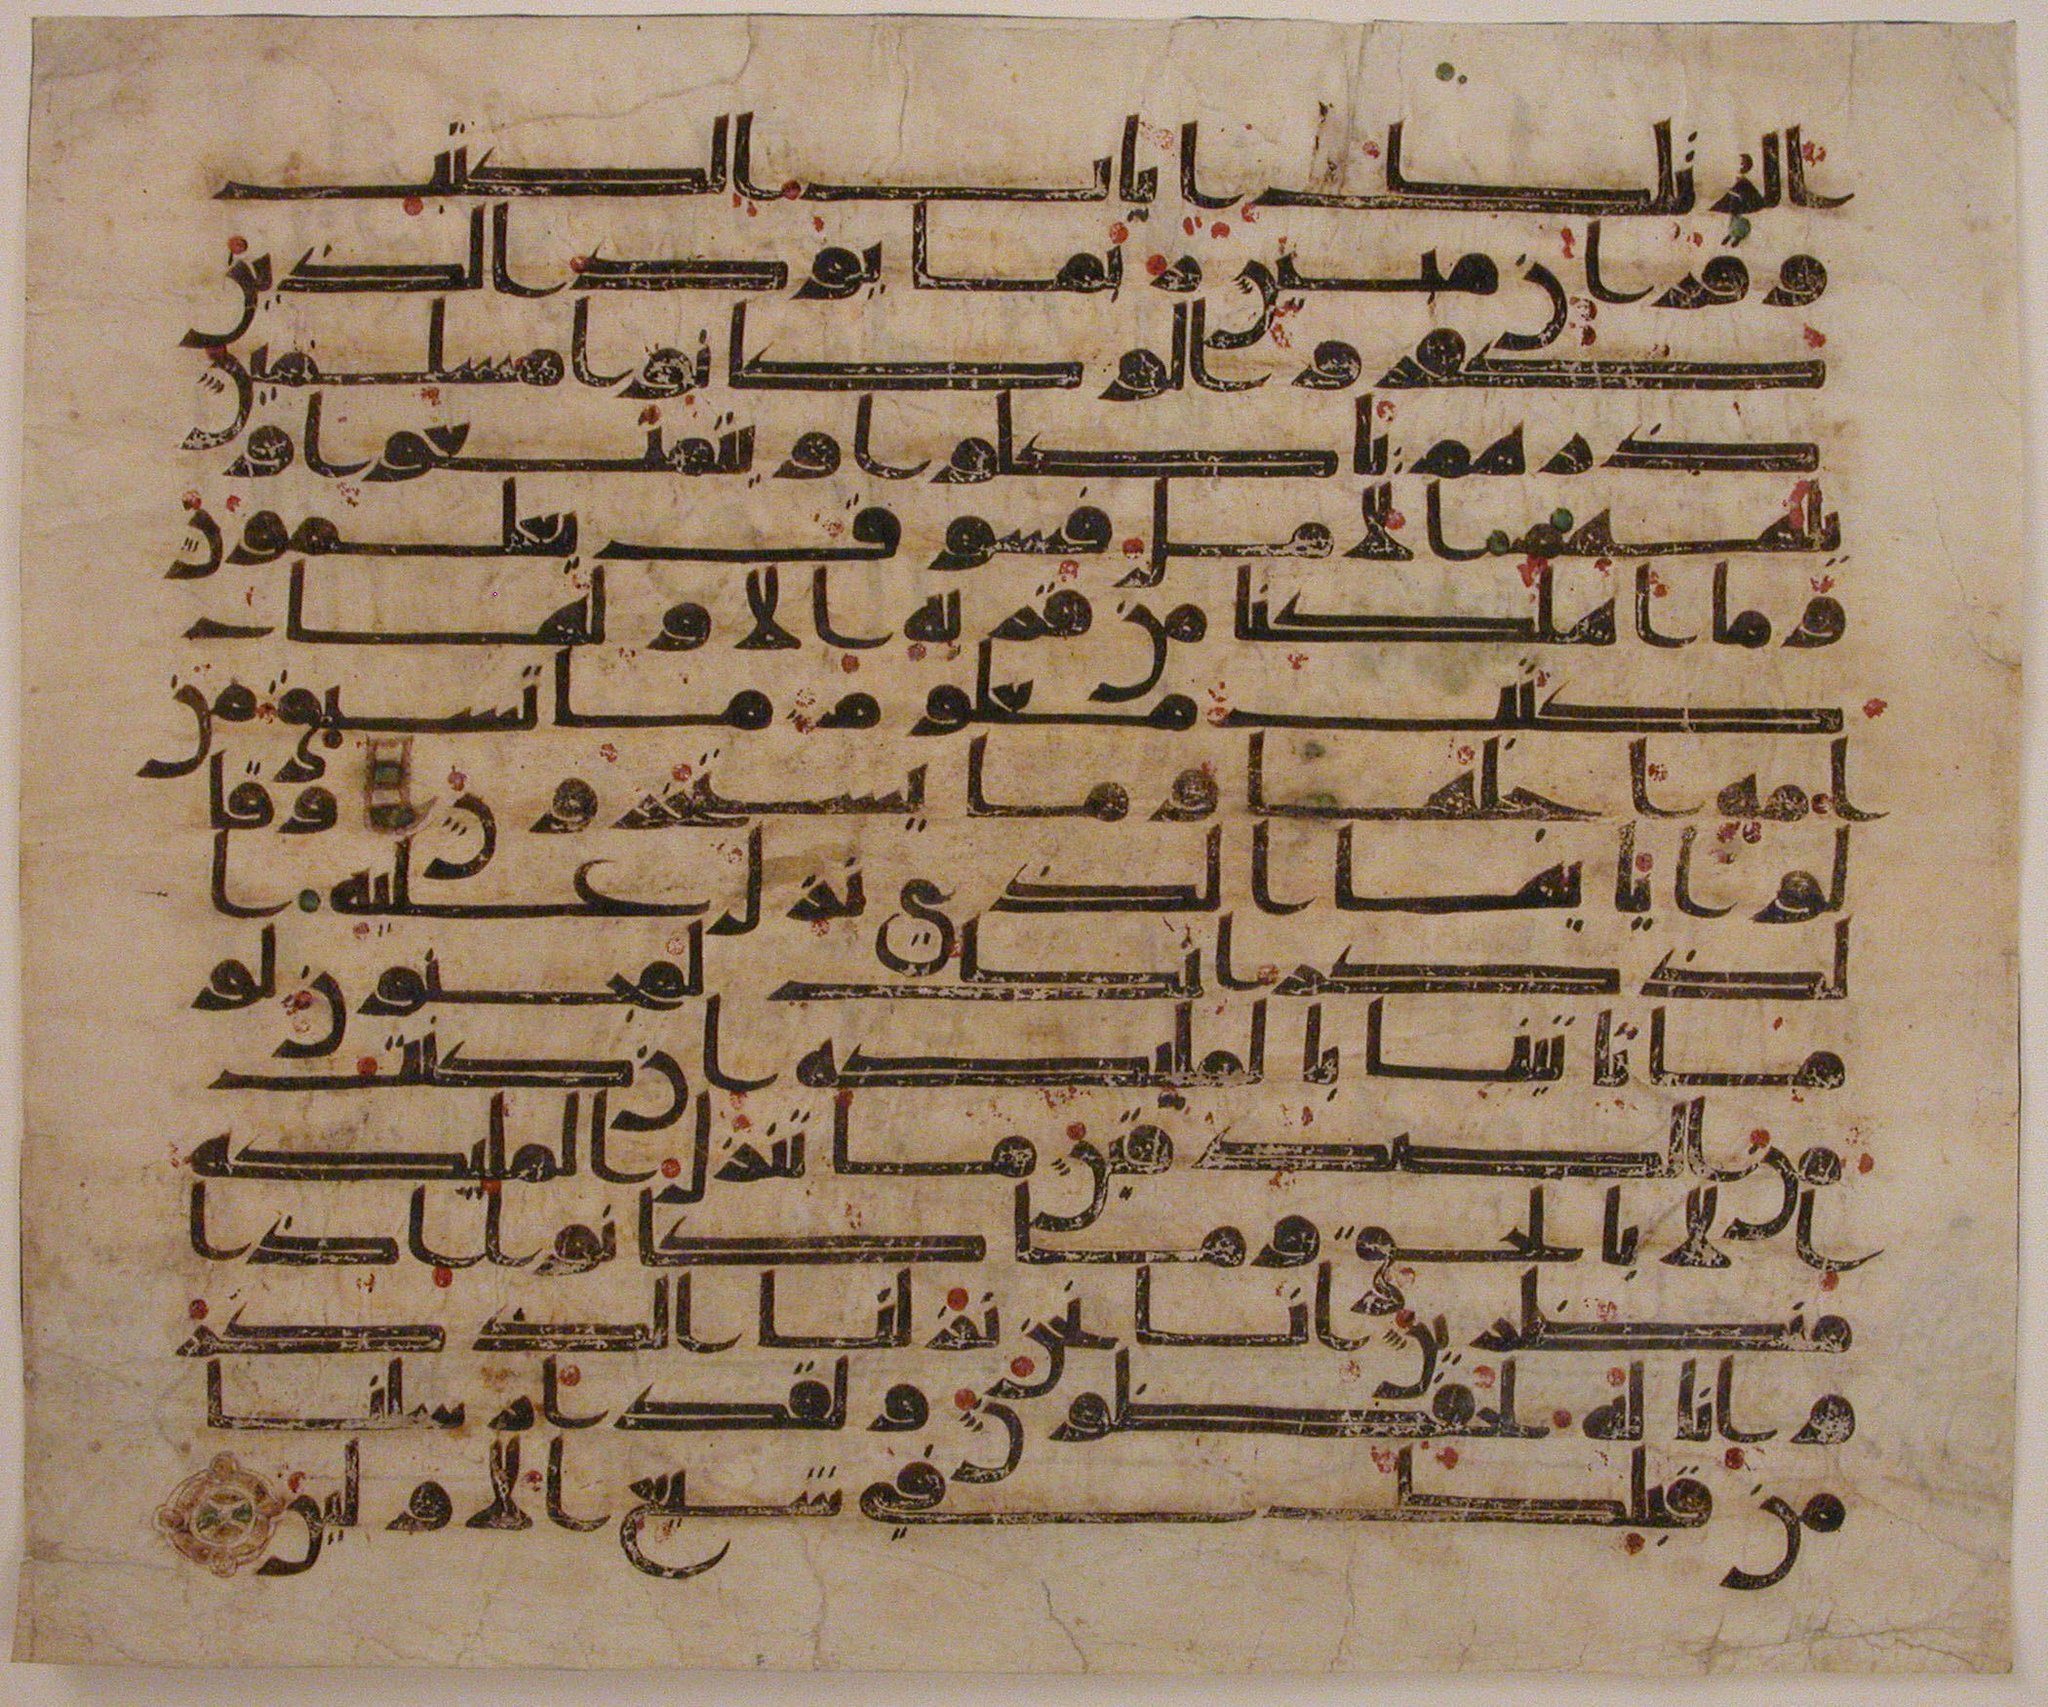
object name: folio from a non illustrated manuscript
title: Folio from a Qur'an Manuscript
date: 751-800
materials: gold, ink, parchment, watercolor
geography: syria